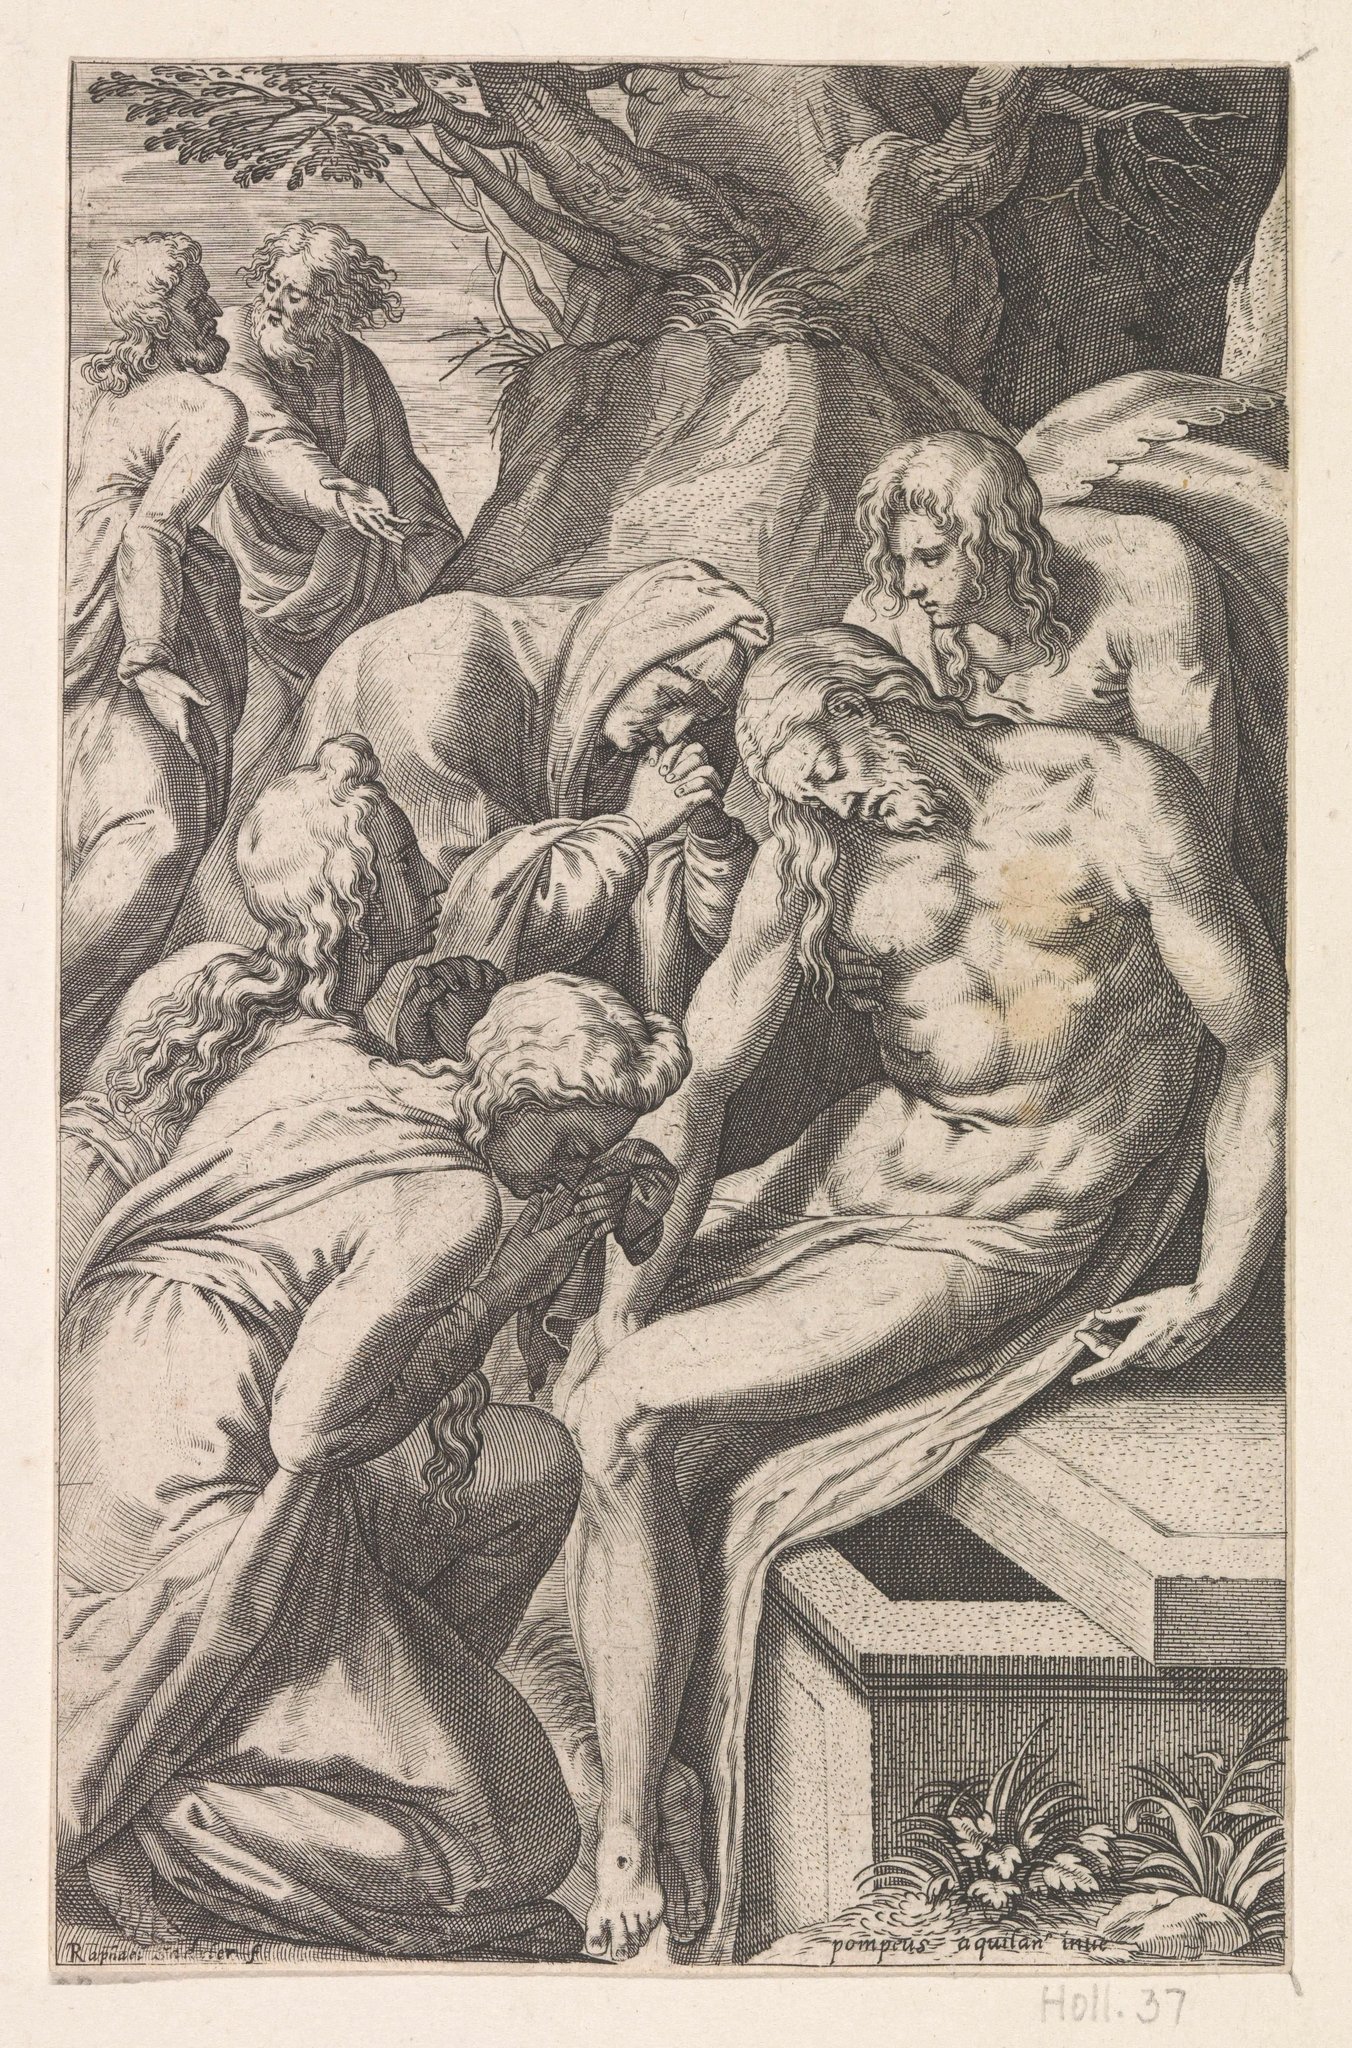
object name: print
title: Bewening en graflegging van Christus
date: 1570-1632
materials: paper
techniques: engraving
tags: lamentation over the dead christ by his relatives and friends (christ usually without crown of thorns)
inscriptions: collector's mark: Lugt 2228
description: Christus wordt door zijn familie en vrienden beweend en in een graftombe gelegd.